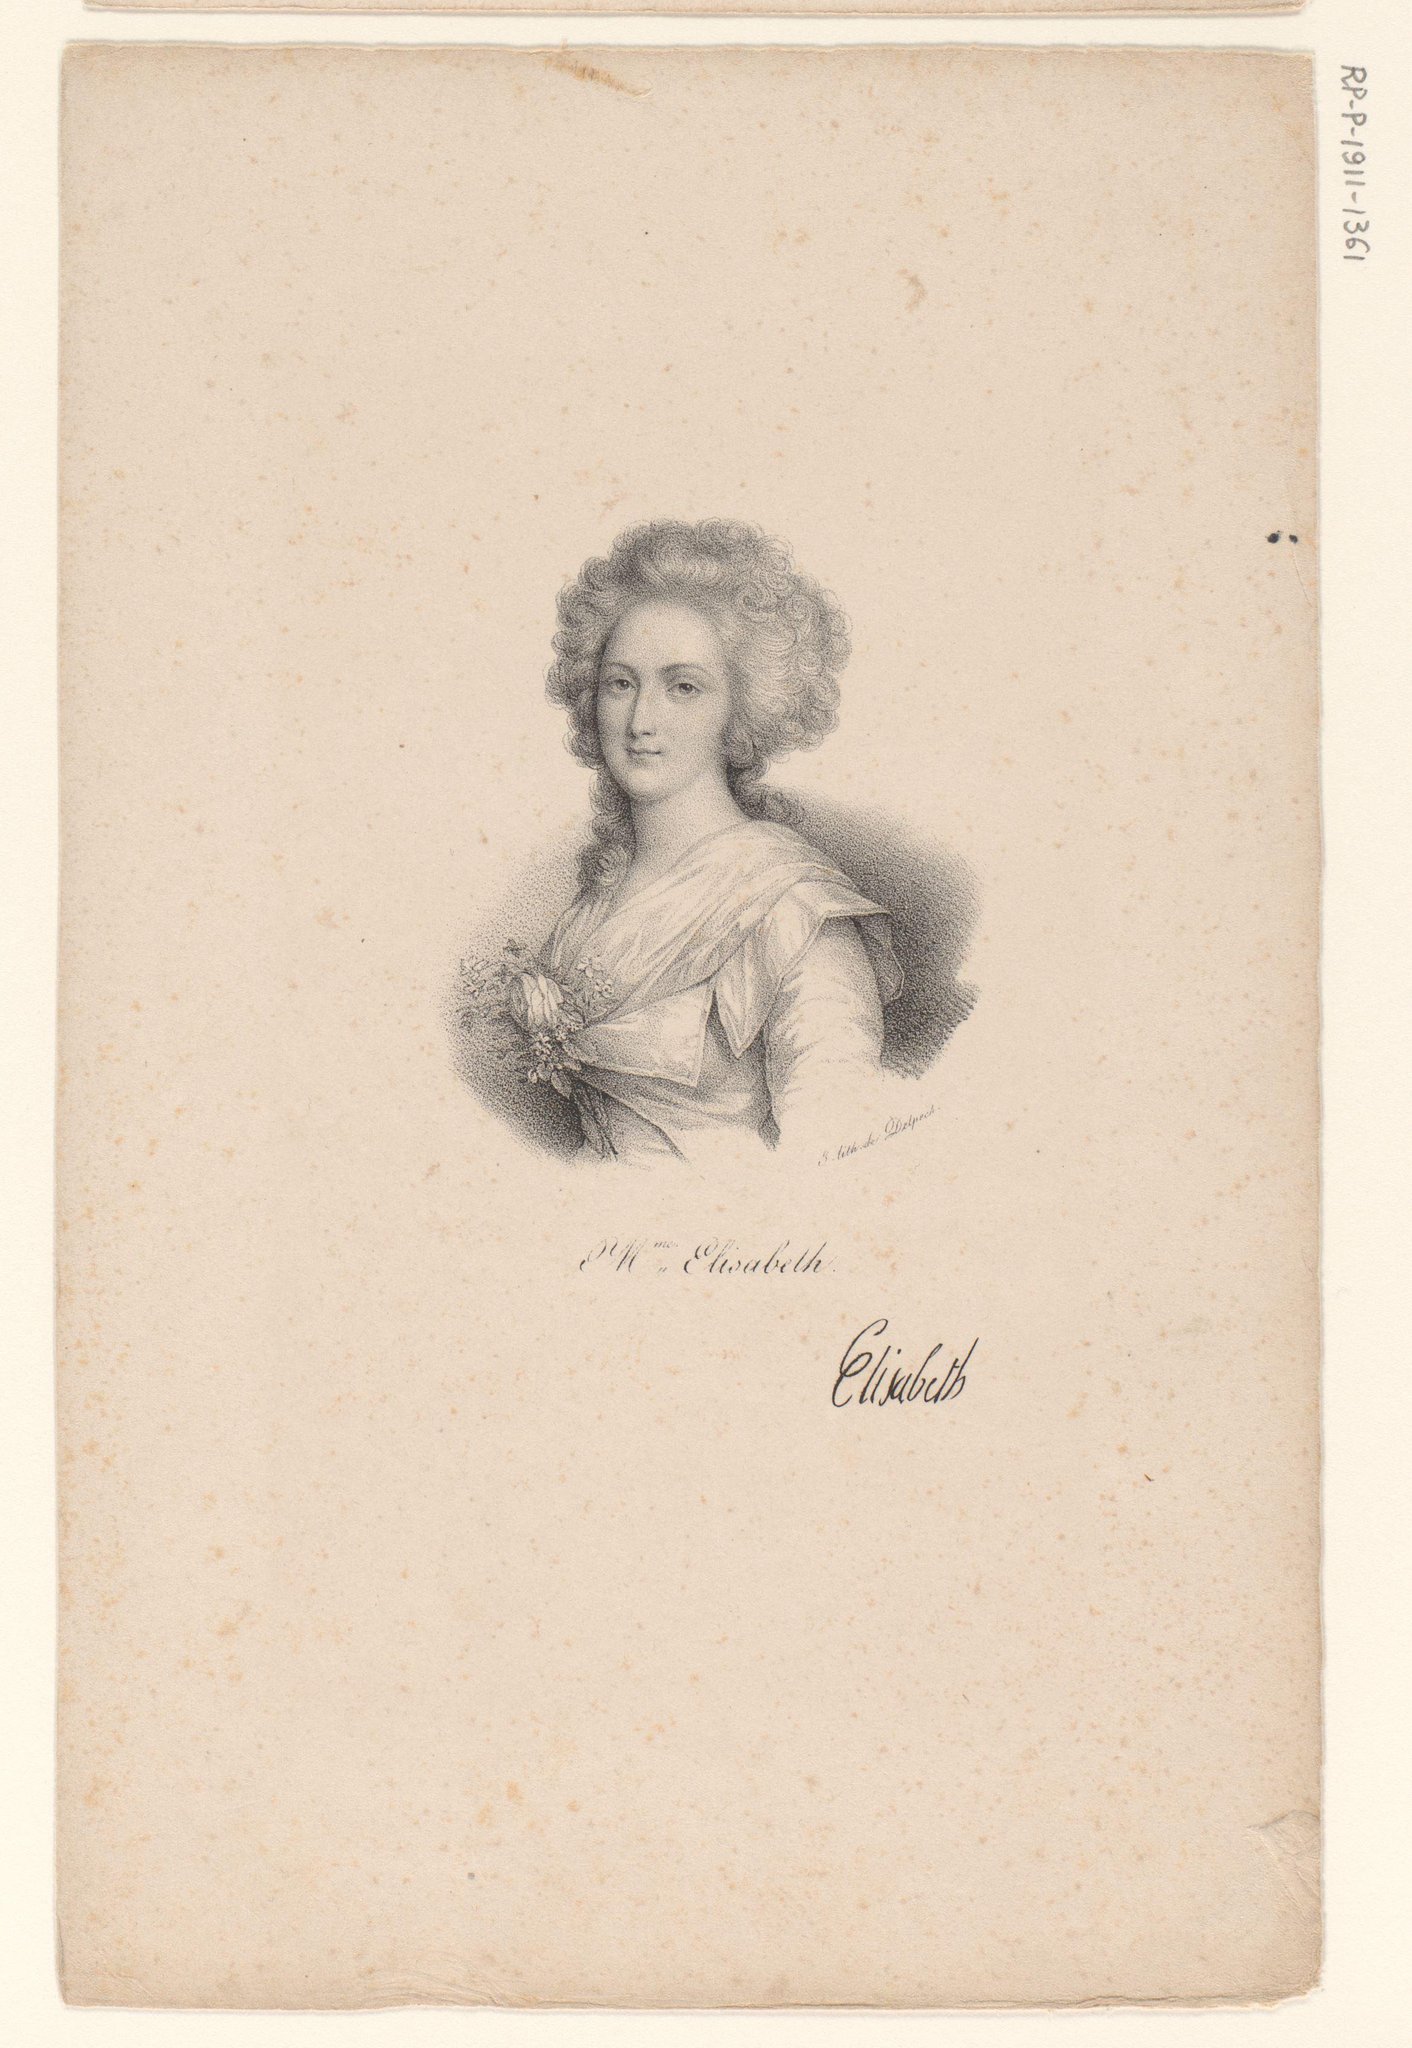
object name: print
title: M.me Elisabeth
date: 1818-1842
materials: paper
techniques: lithograph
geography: paris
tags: historical persons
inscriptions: collector's mark: Lugt 2228a